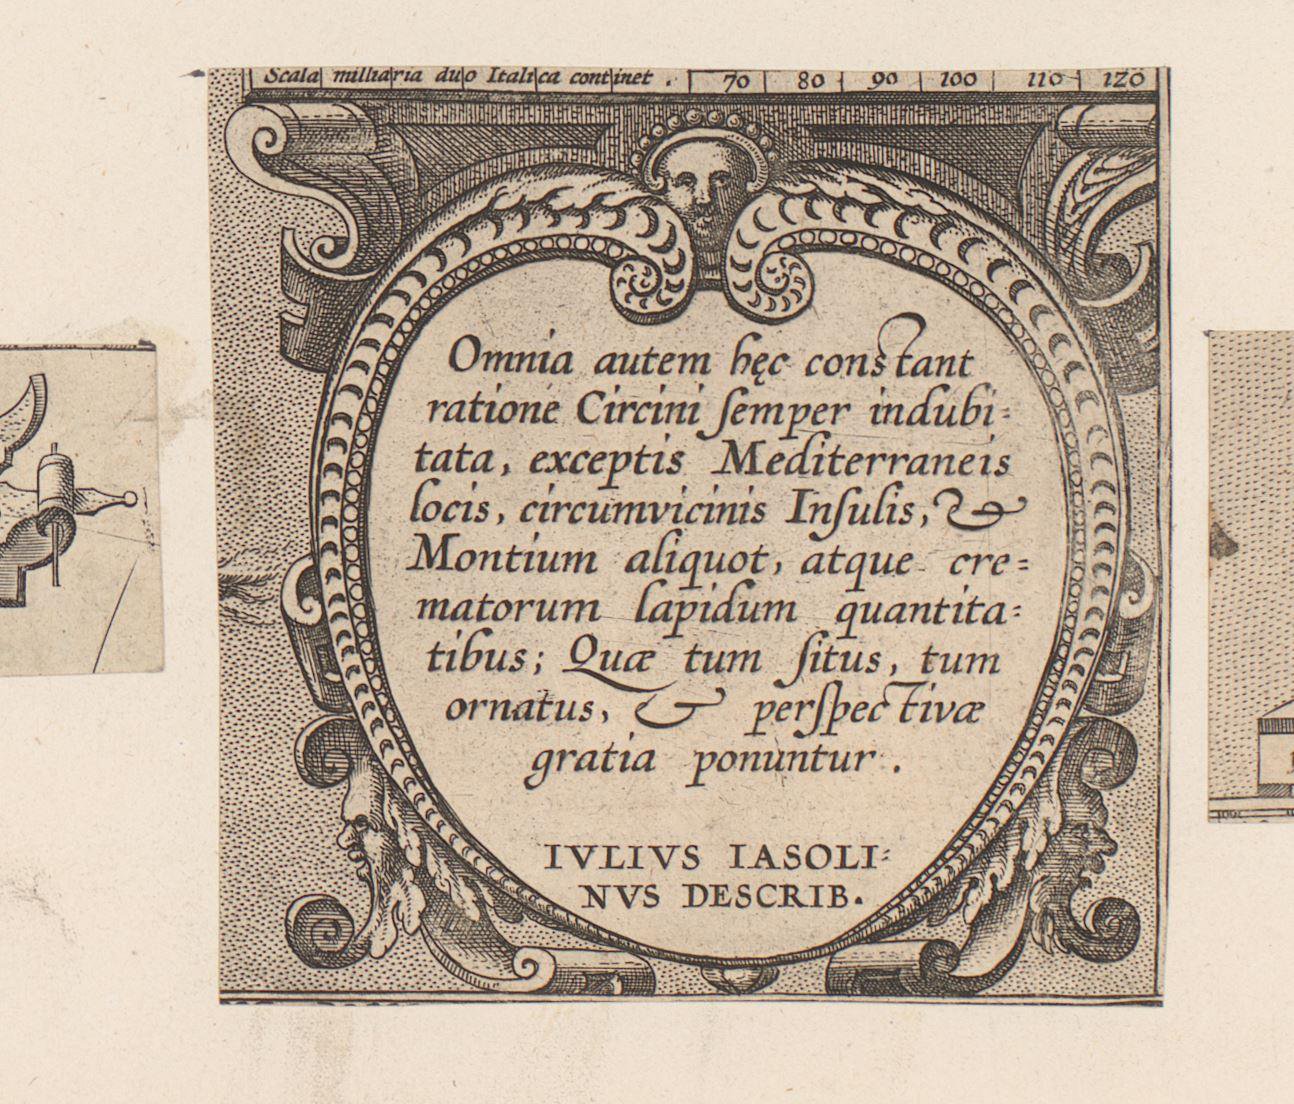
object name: ornament print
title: Cartouche van een kaart van het eiland Ischia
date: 1595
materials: paper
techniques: engraving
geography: antwerp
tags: ornament ~ cartouche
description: Plompebladvormige cartouche met rolwerk en enkele maskers. De cartouche is een fragment van een kaart van het eiland Ischia. De prent maakt deel uit van een album.